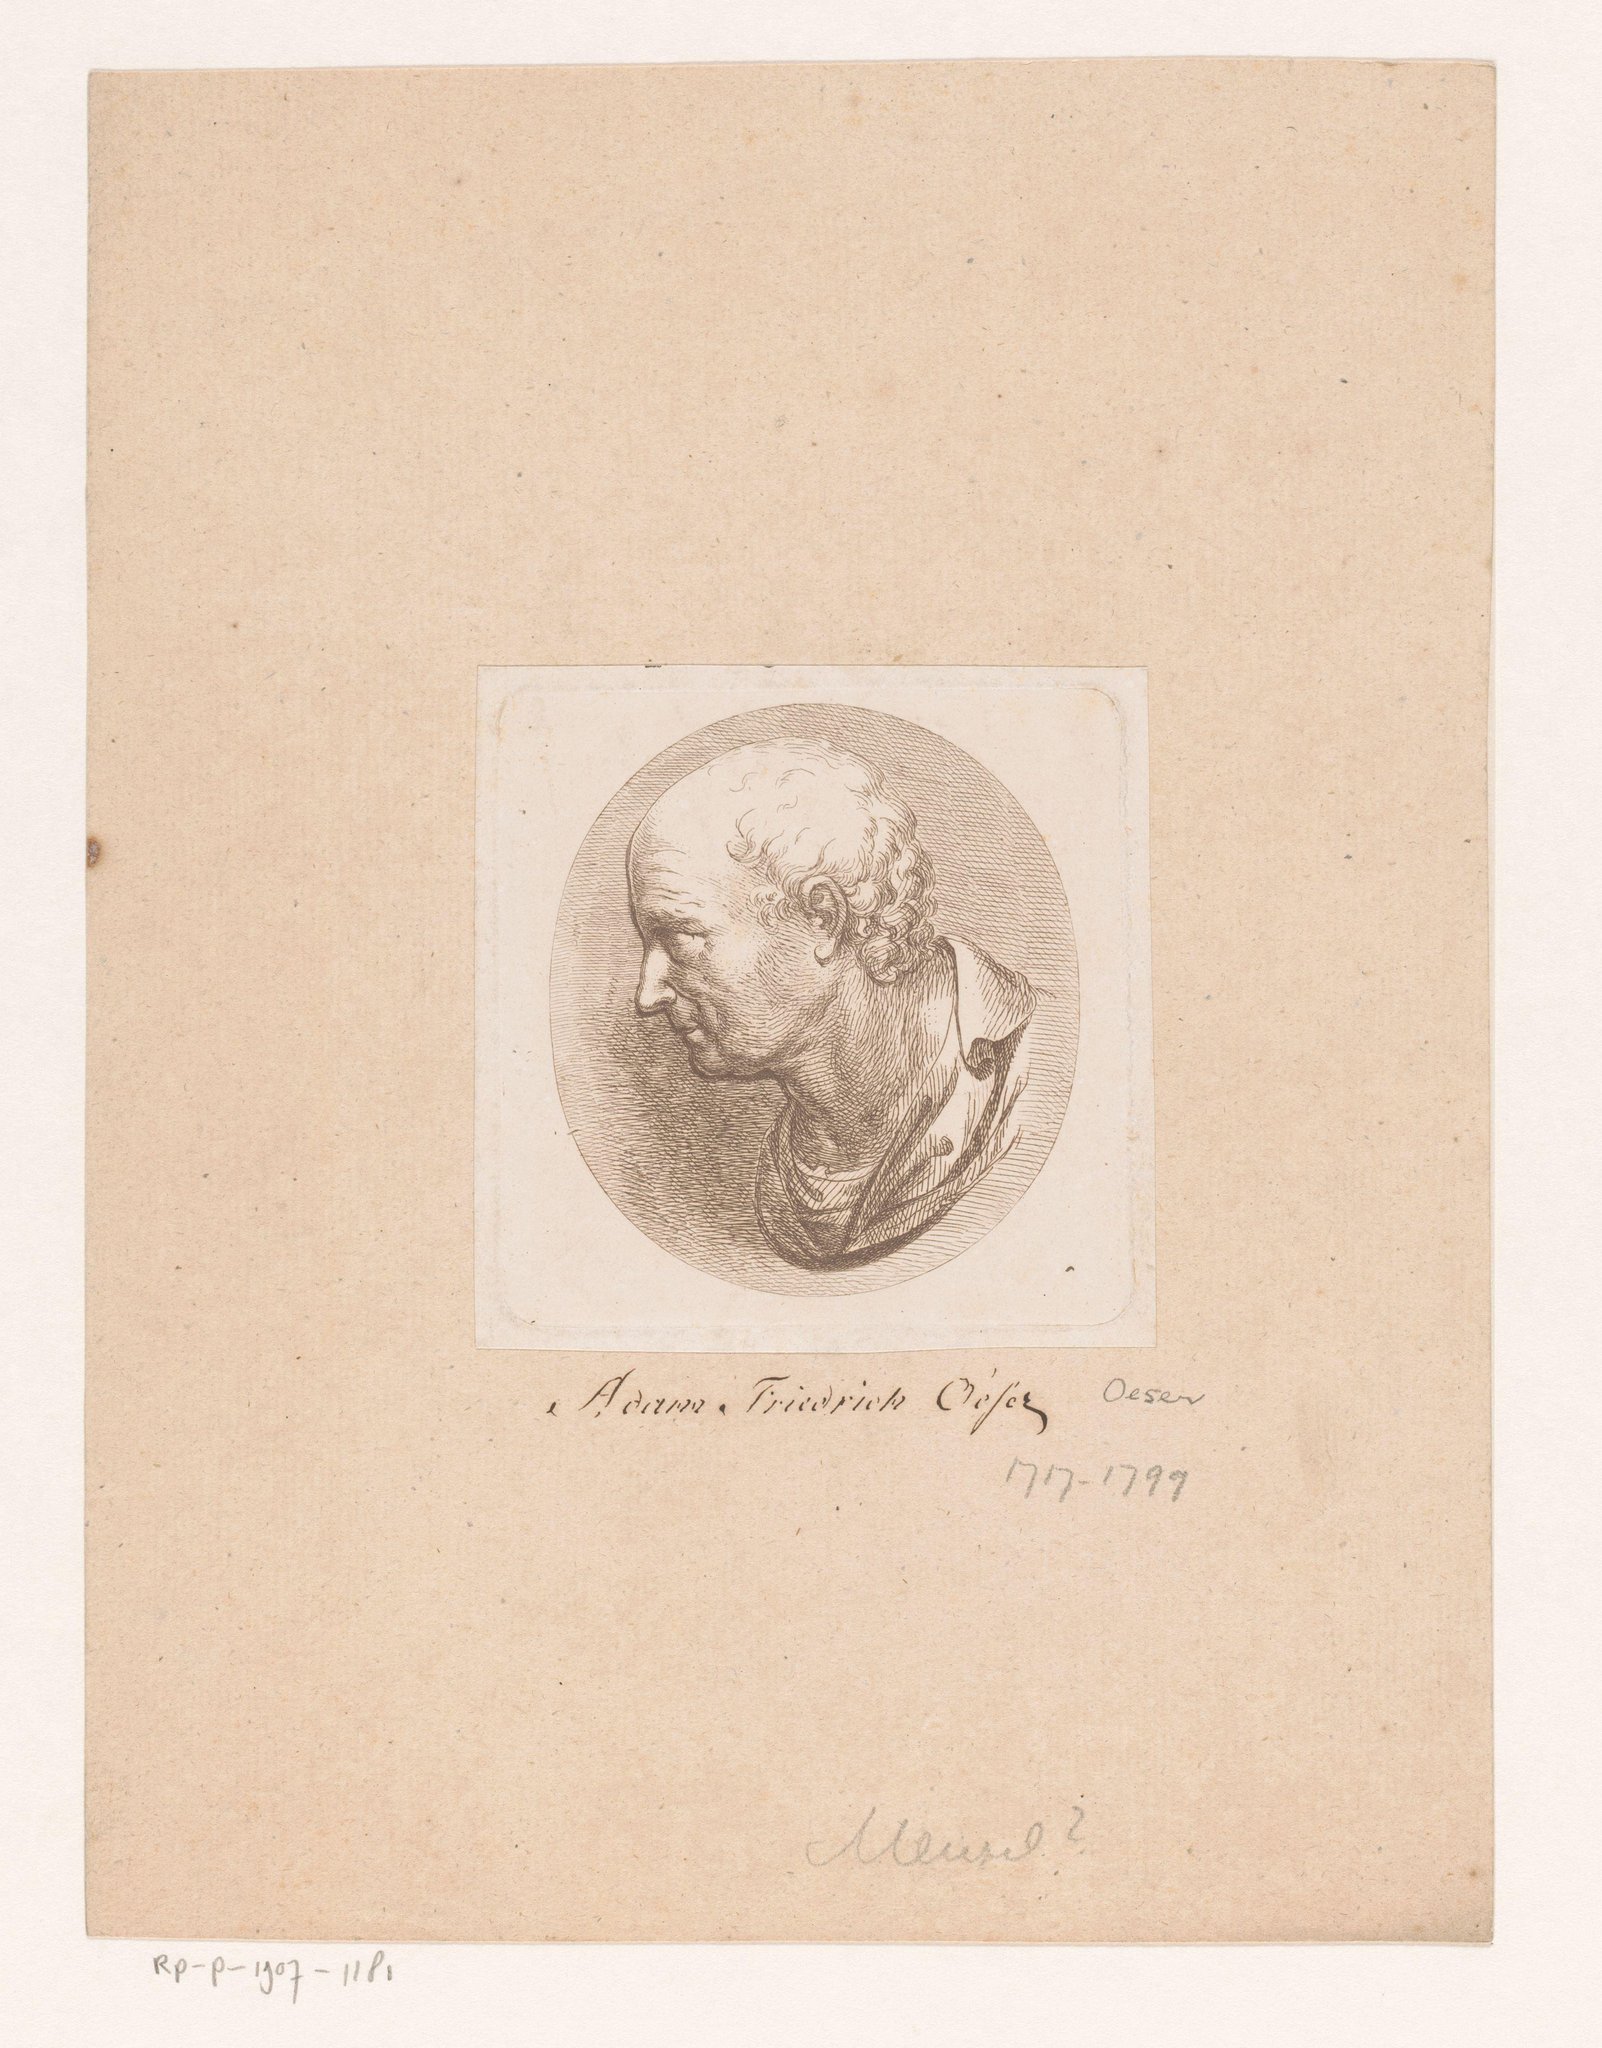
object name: print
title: Overlijdensportret van Adam Friedrich Oeser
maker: Anonymous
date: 1799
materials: paper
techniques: etching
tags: painter, sculptor, adam friedrich oeser, portrait, self-portrait of painter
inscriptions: collector's mark: Lugt 2228